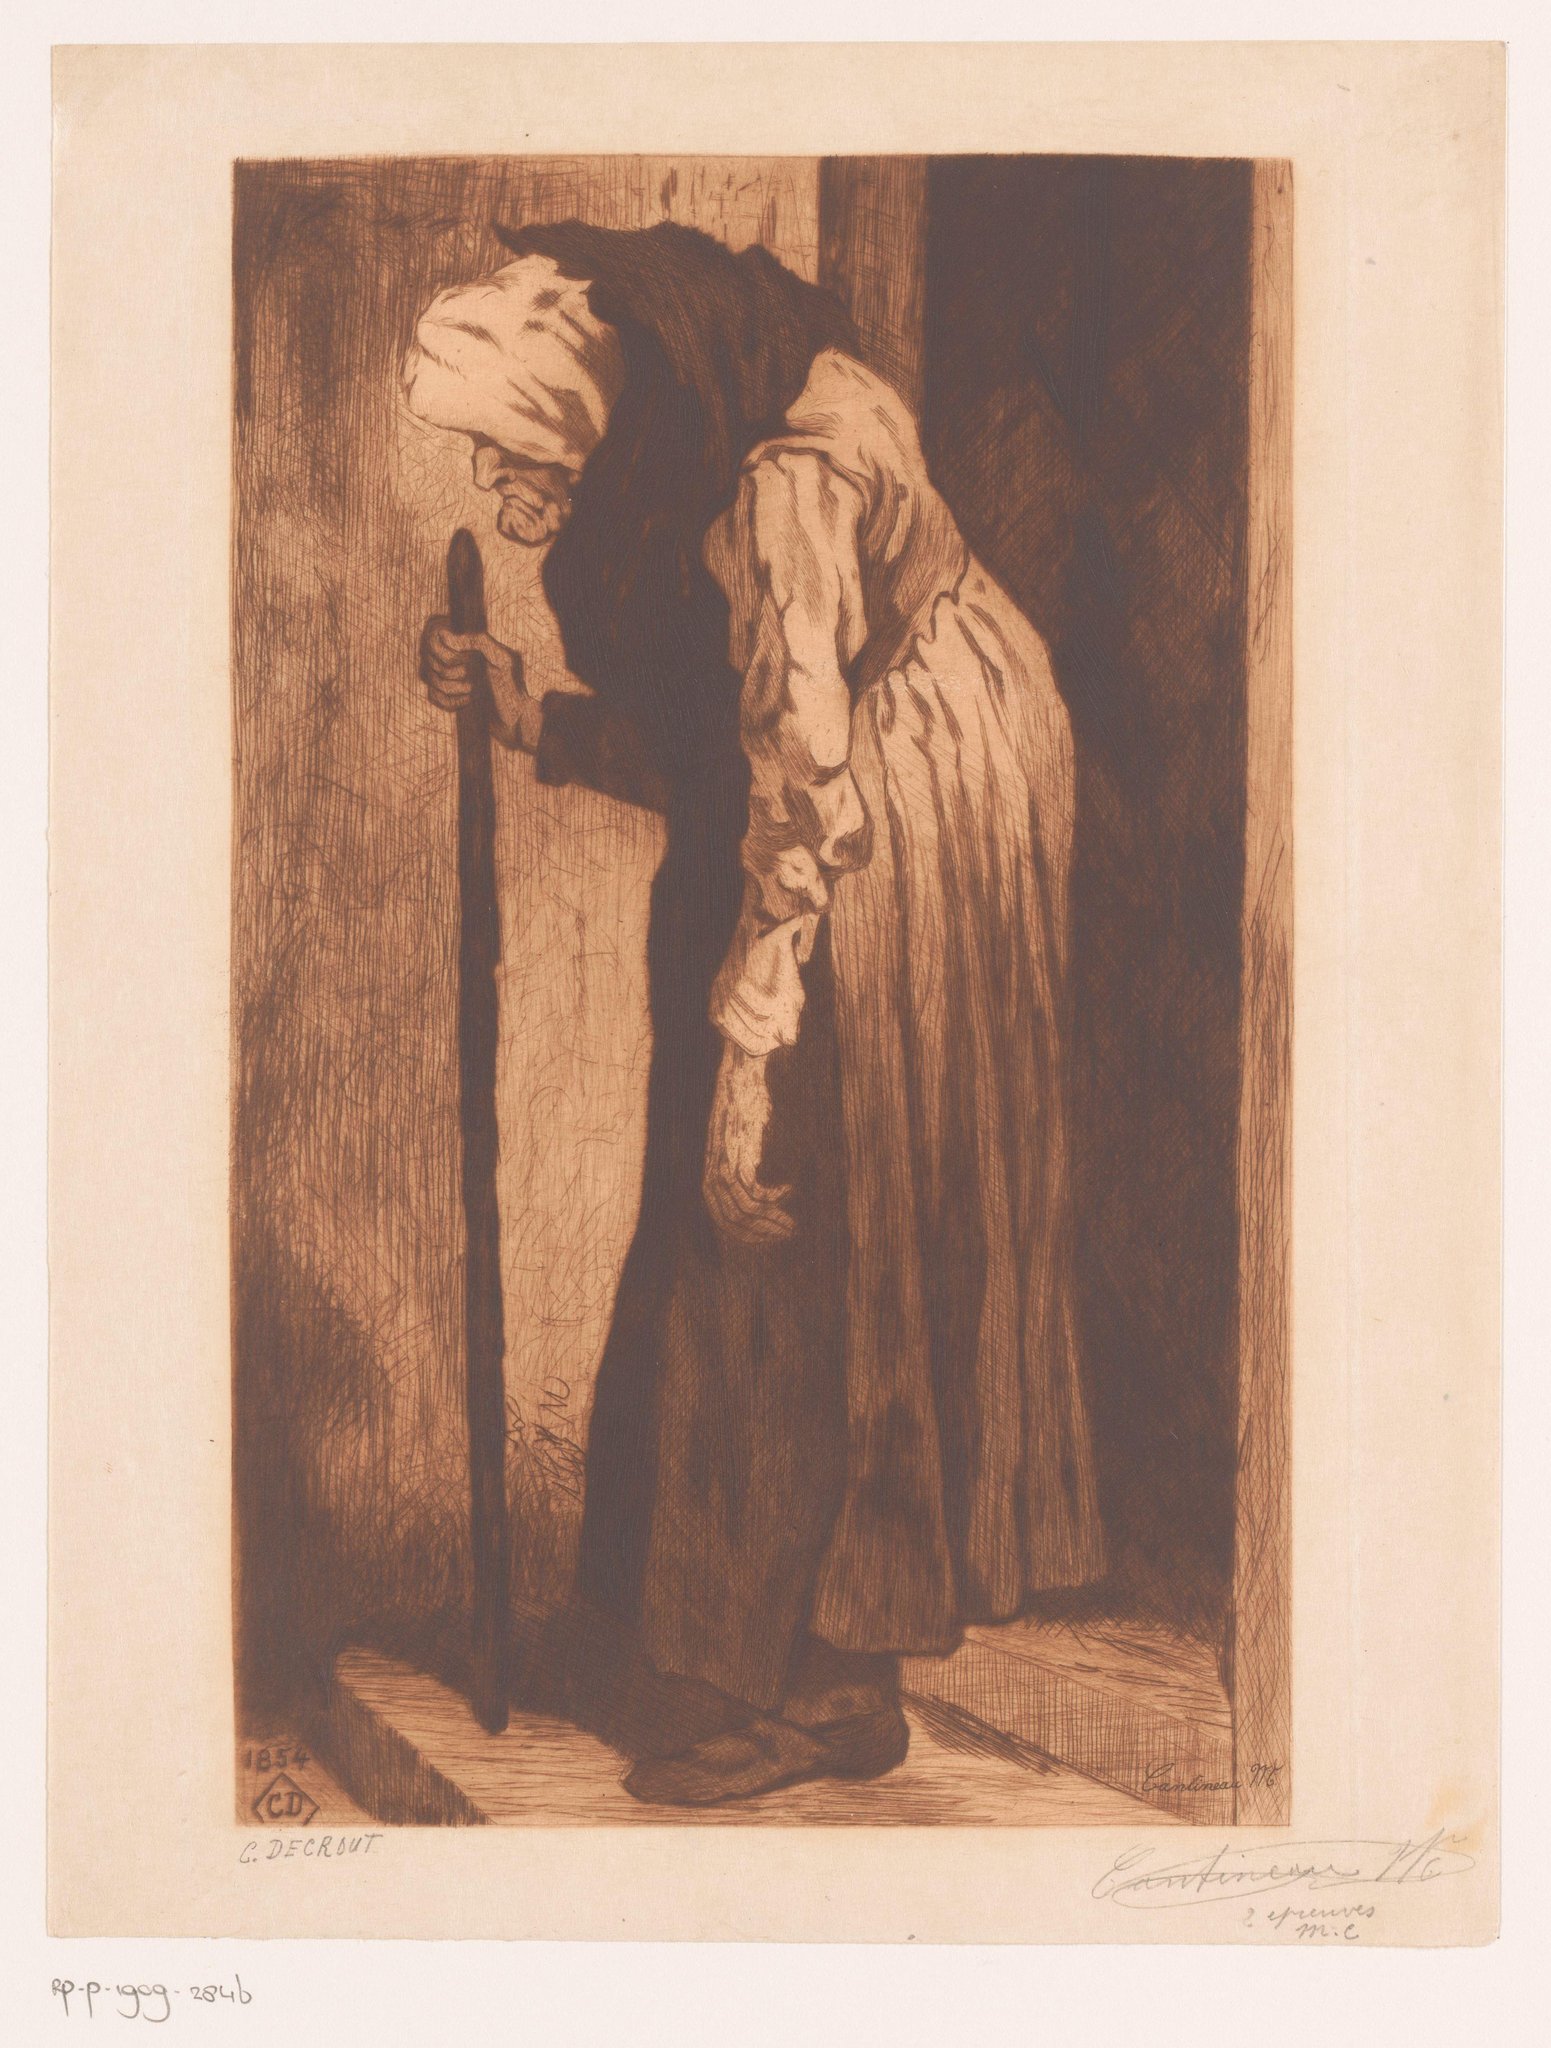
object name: print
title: Op een stok leunende oude vrouw in een deuropening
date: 1885-1909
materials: paper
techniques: drypoint, etching, intaglio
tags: old woman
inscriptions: collector's mark: Lugt 2228, annotation: ‘2 epreuves’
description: Sterfdatum prentmaker onbekend. Derhalve is voor bepaling van de rechten van dit object de verwervingsdatum aangehouden.